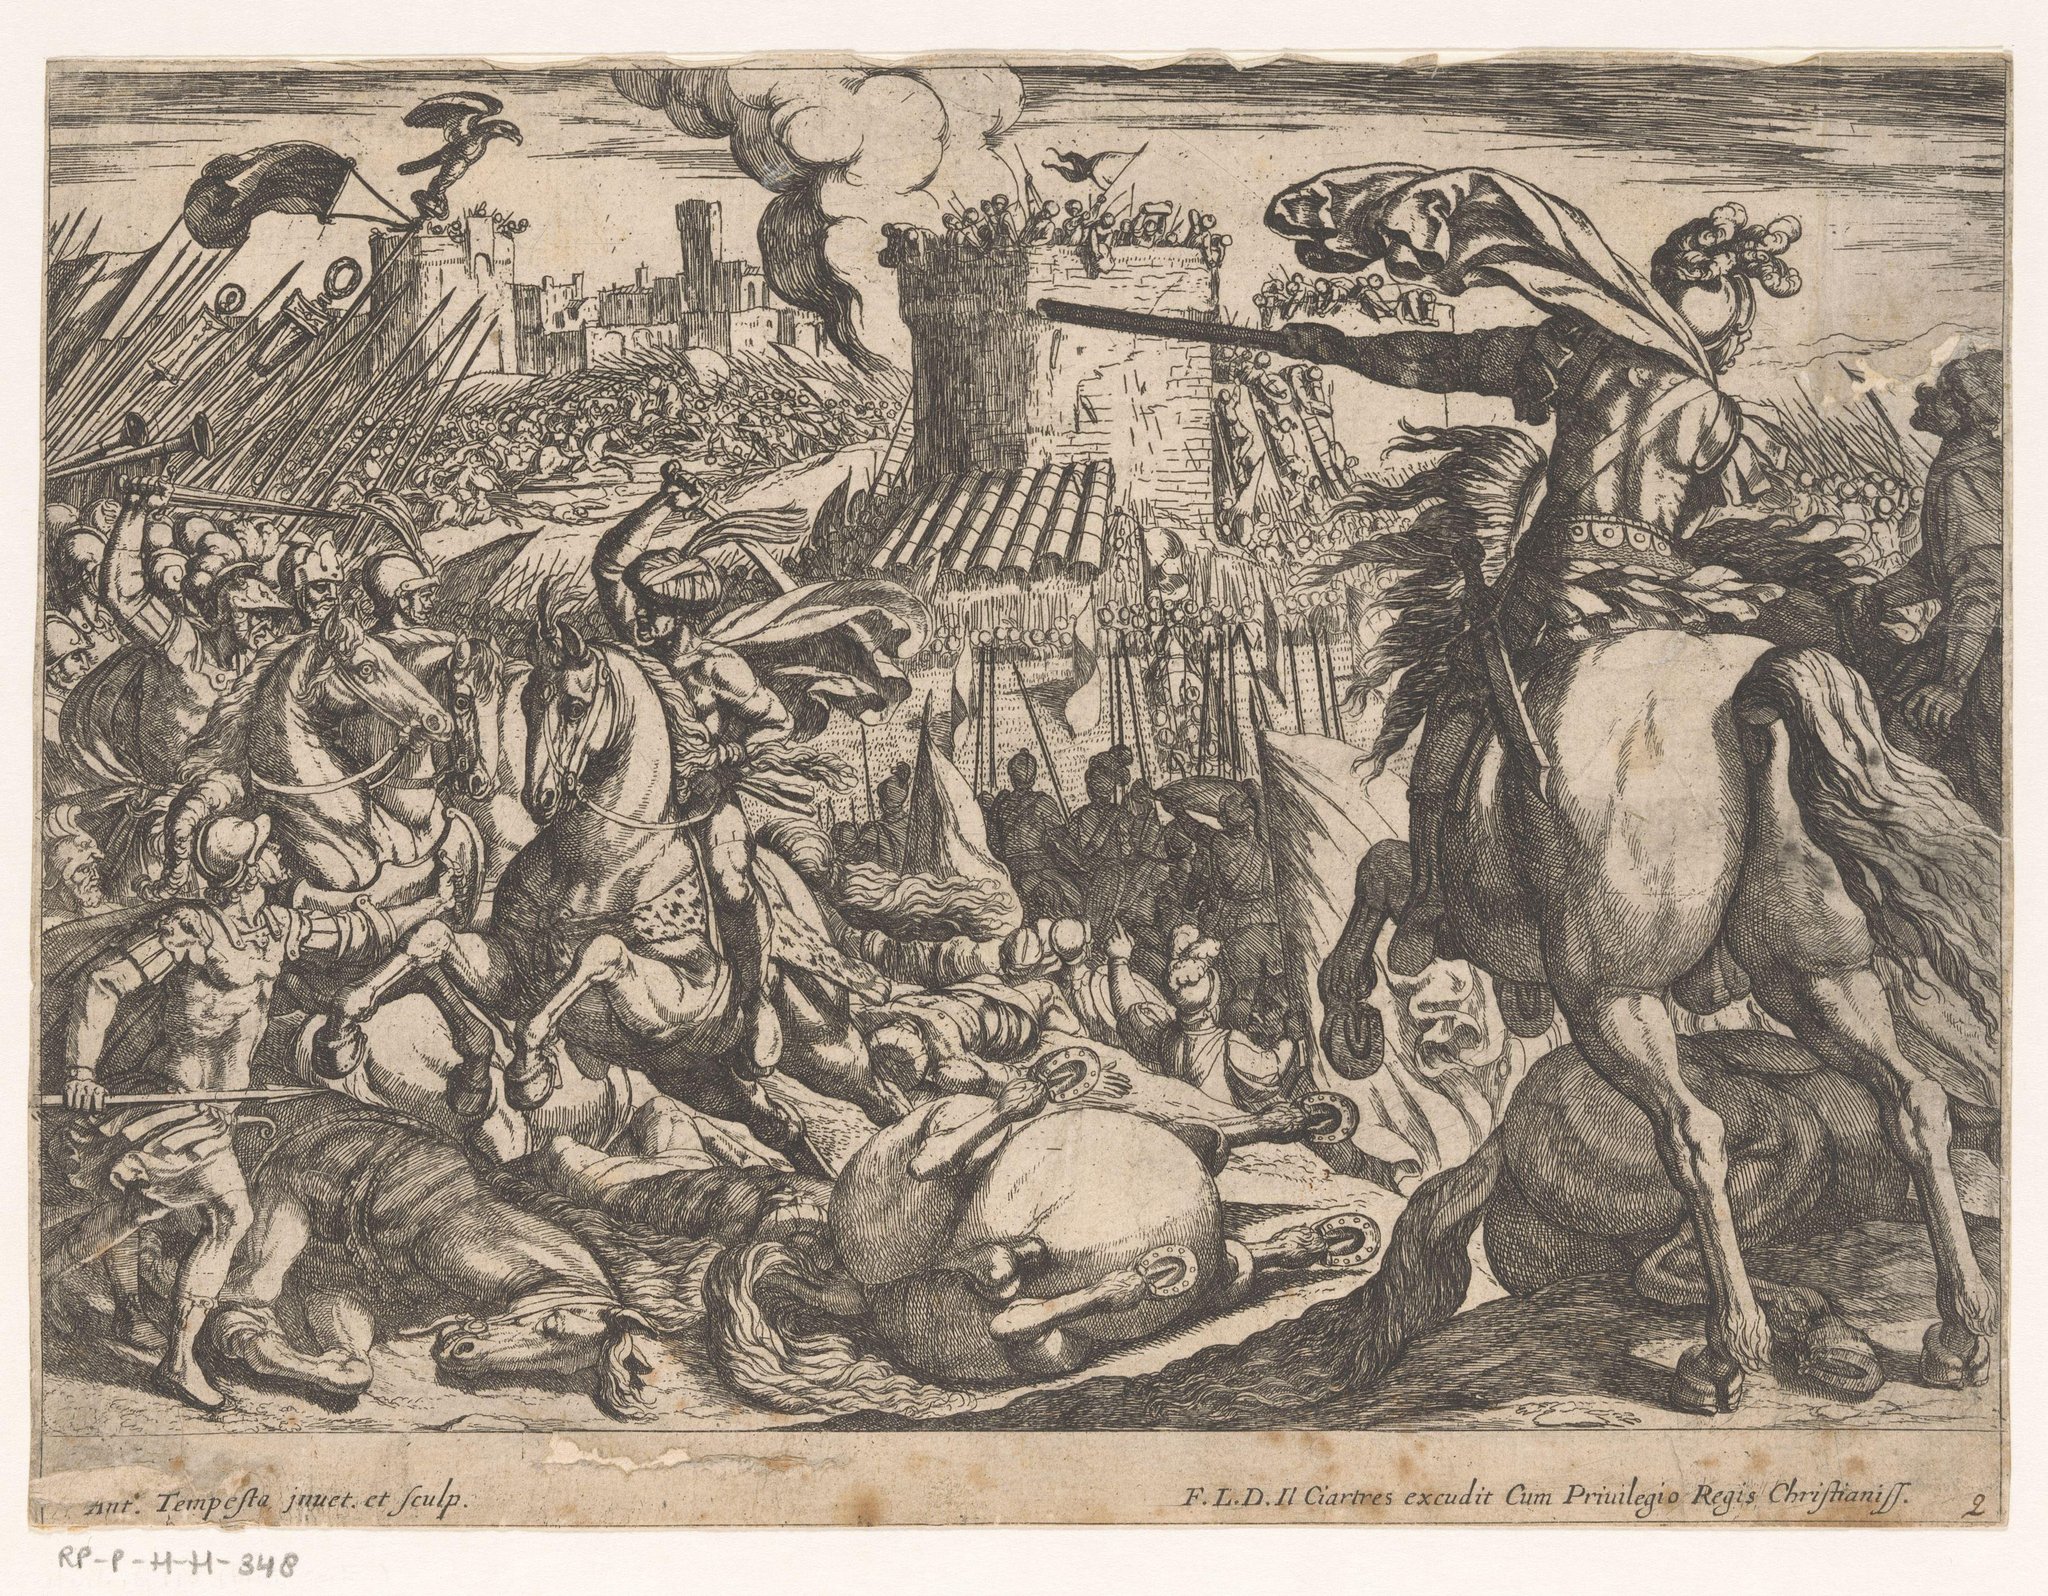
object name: print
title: Ruitergevecht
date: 1565-1630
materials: paper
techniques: etching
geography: vatican city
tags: battle, warfare; military affairs (+ cavalry, horsemen), the soldier; the soldier's life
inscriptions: collector's mark: ‘Hinloopen’, collector's mark: Lugt 11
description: Strijdende soldaten te paard voor een stad.